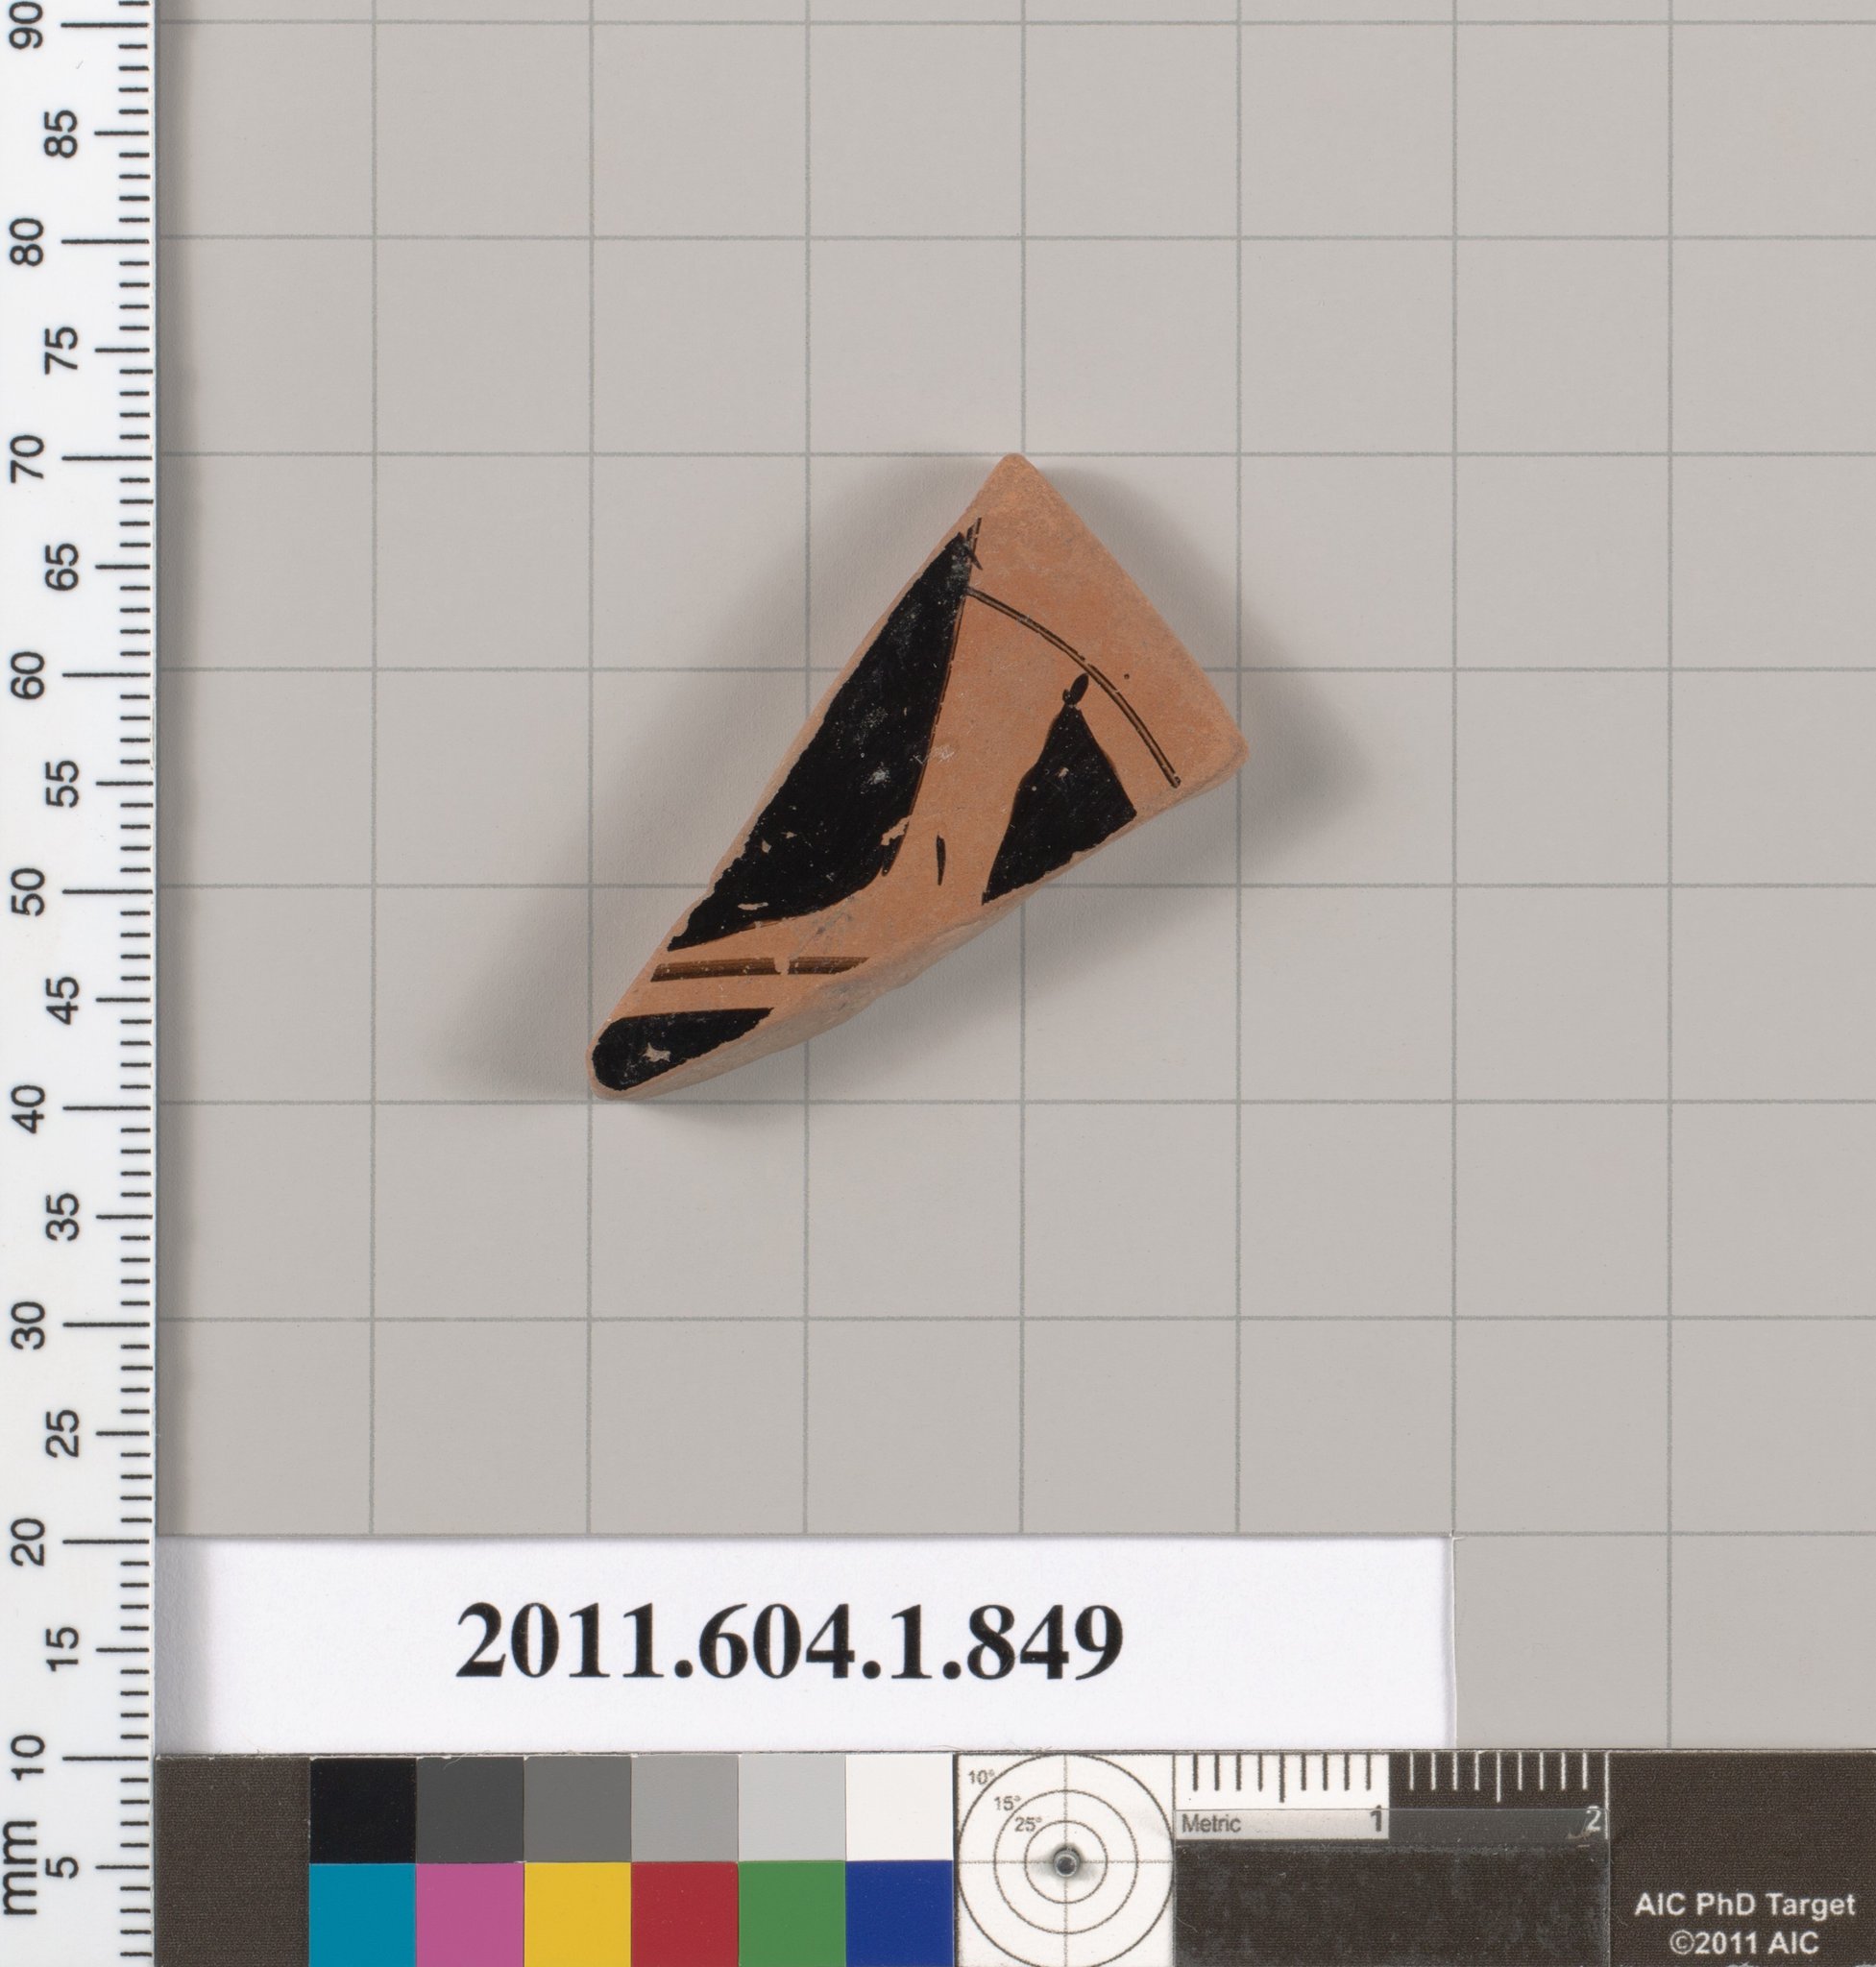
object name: kylix fragment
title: Terracotta fragment of a kylix (drinking cup)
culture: greek, attic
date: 500-451 BCE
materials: terracotta